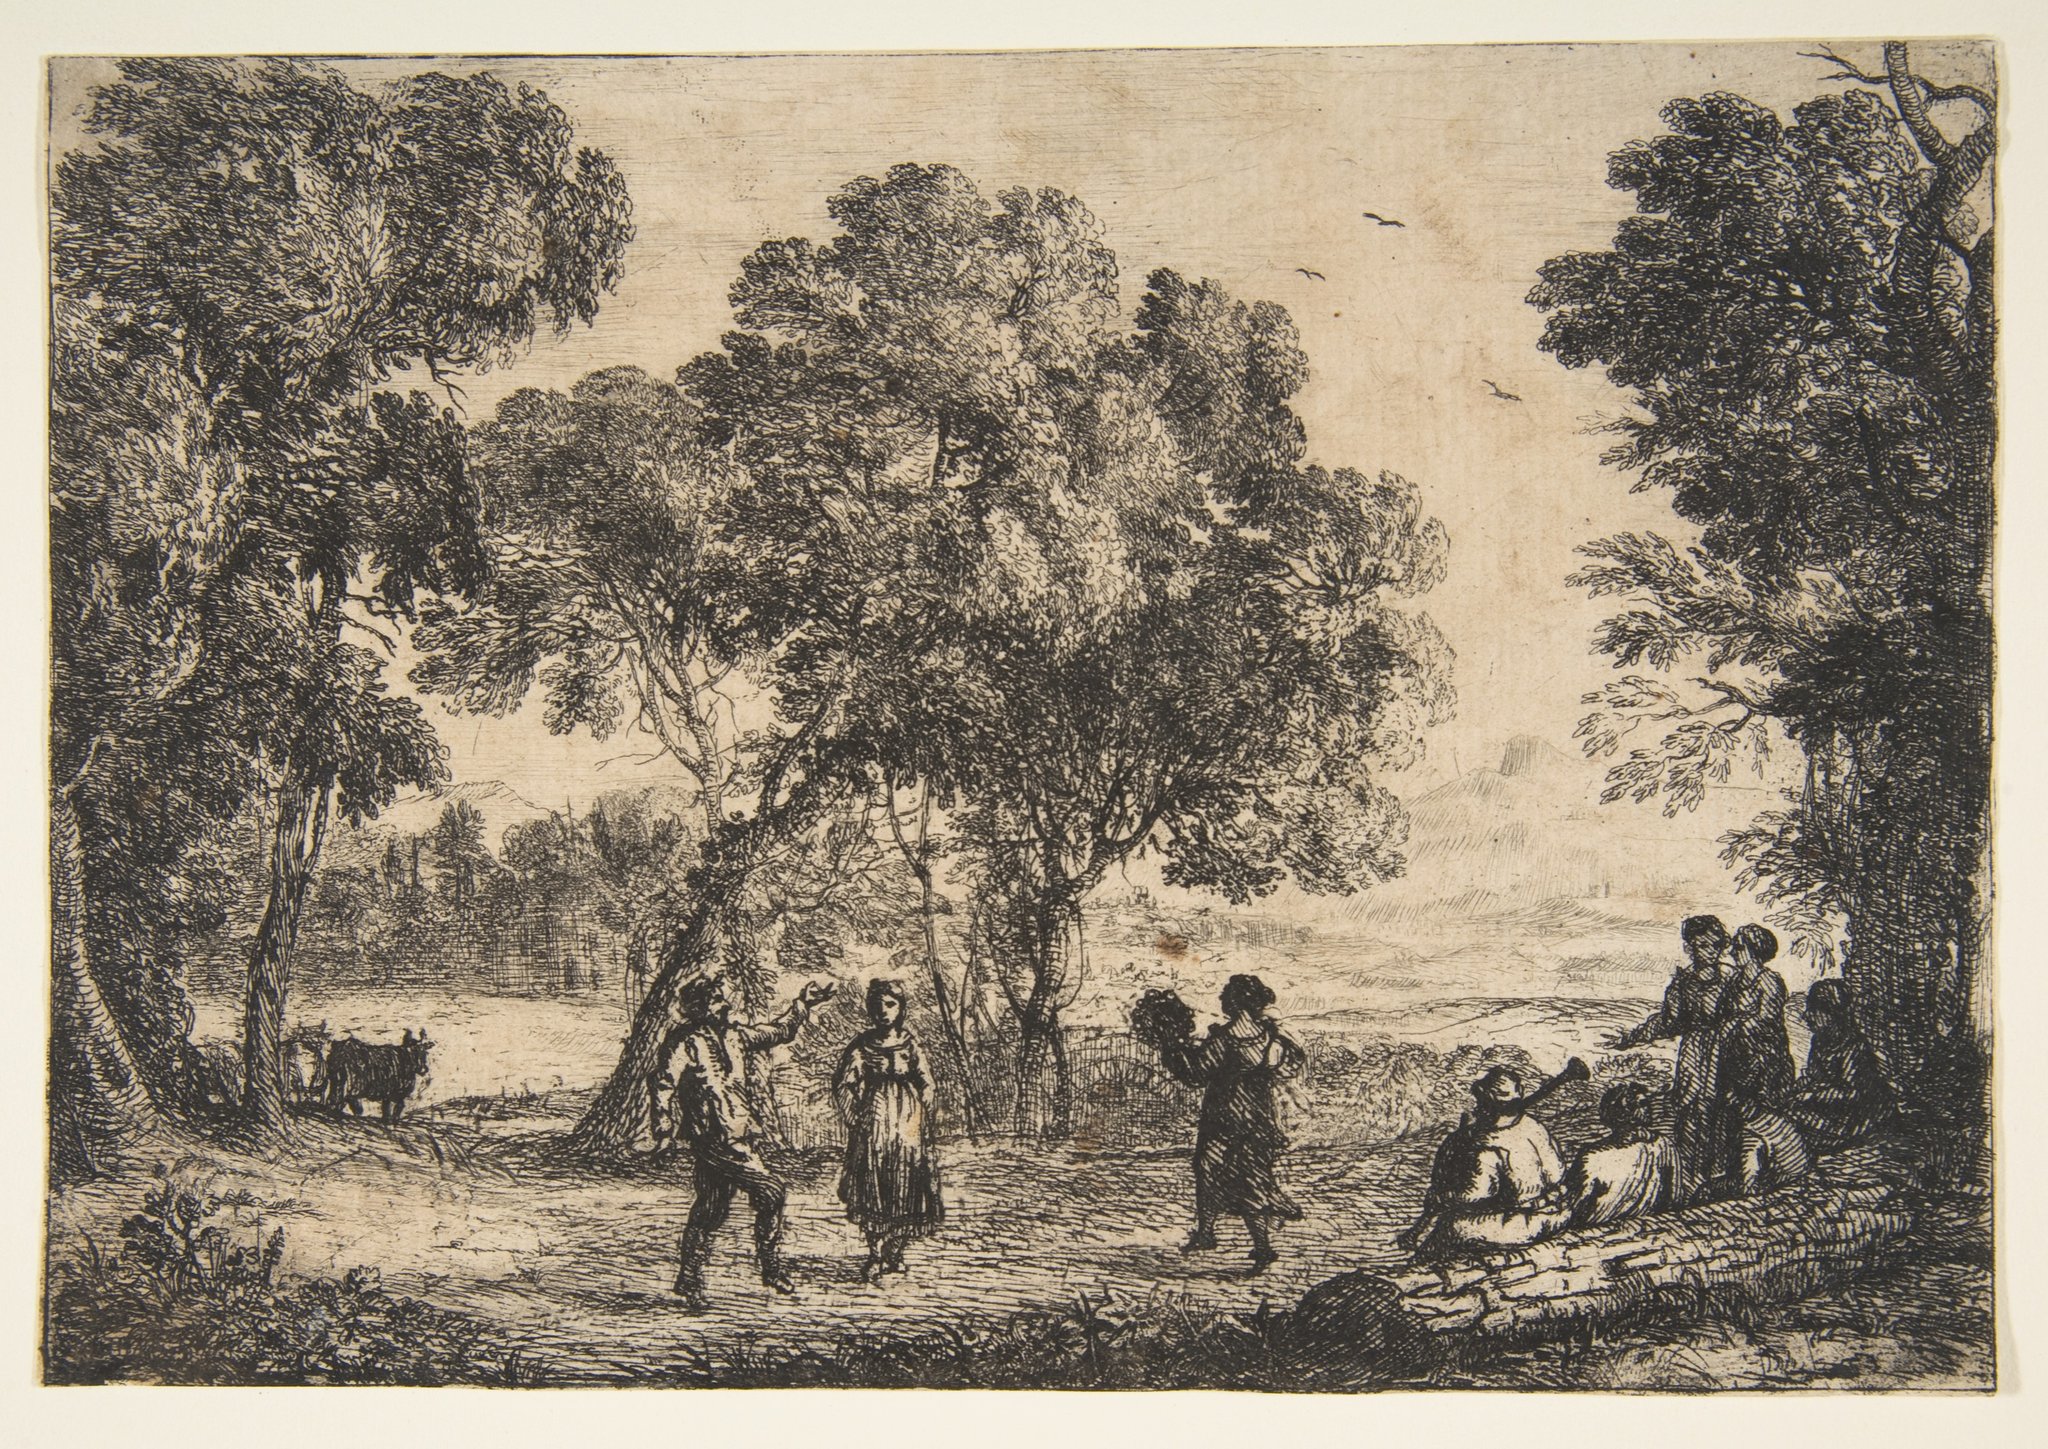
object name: print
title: The Country Dance (Small Plate)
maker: claude lorrain (claude gellée)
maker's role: artist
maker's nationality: french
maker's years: 1604-1682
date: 1637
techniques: etching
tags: musical instruments,men,women,dancing,trees